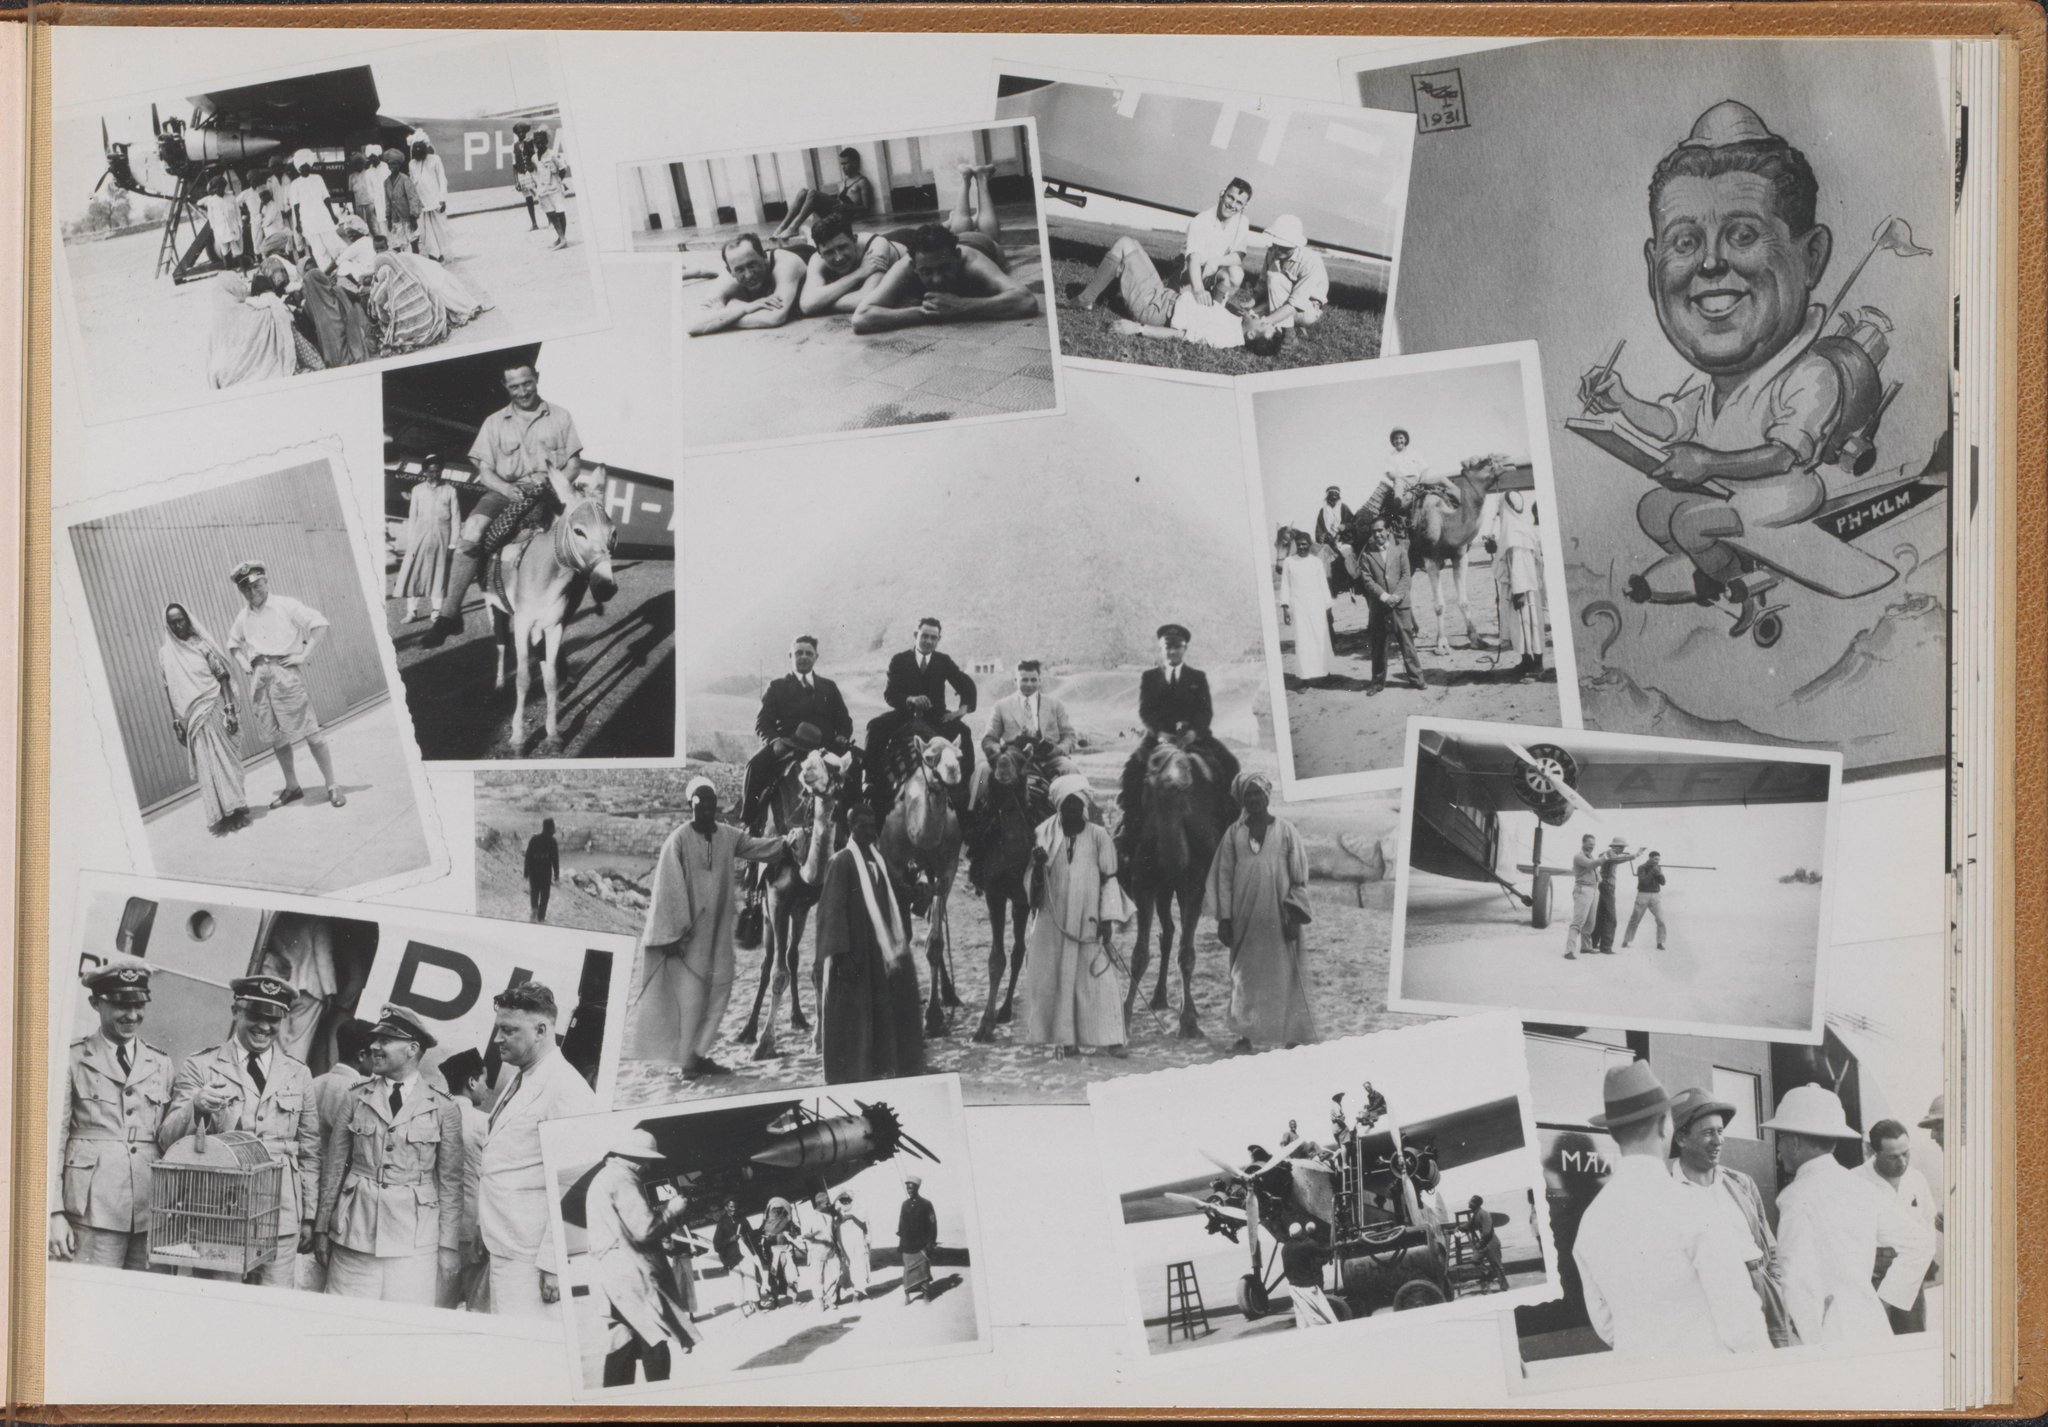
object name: photograph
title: KLM-personeel onderweg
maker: Anonymous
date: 1949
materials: cardboard, paper, photographic support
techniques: gelatin silver print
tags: airborne traffic, aviation, pilot, flight crew, travelling; tourism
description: Albumblad met een compositiefoto van KLM-werknemers tijdens hun vliegreizen. Onderdeel van Herdenkingsalbum van de Indië-lijn van de KLM, deel II.